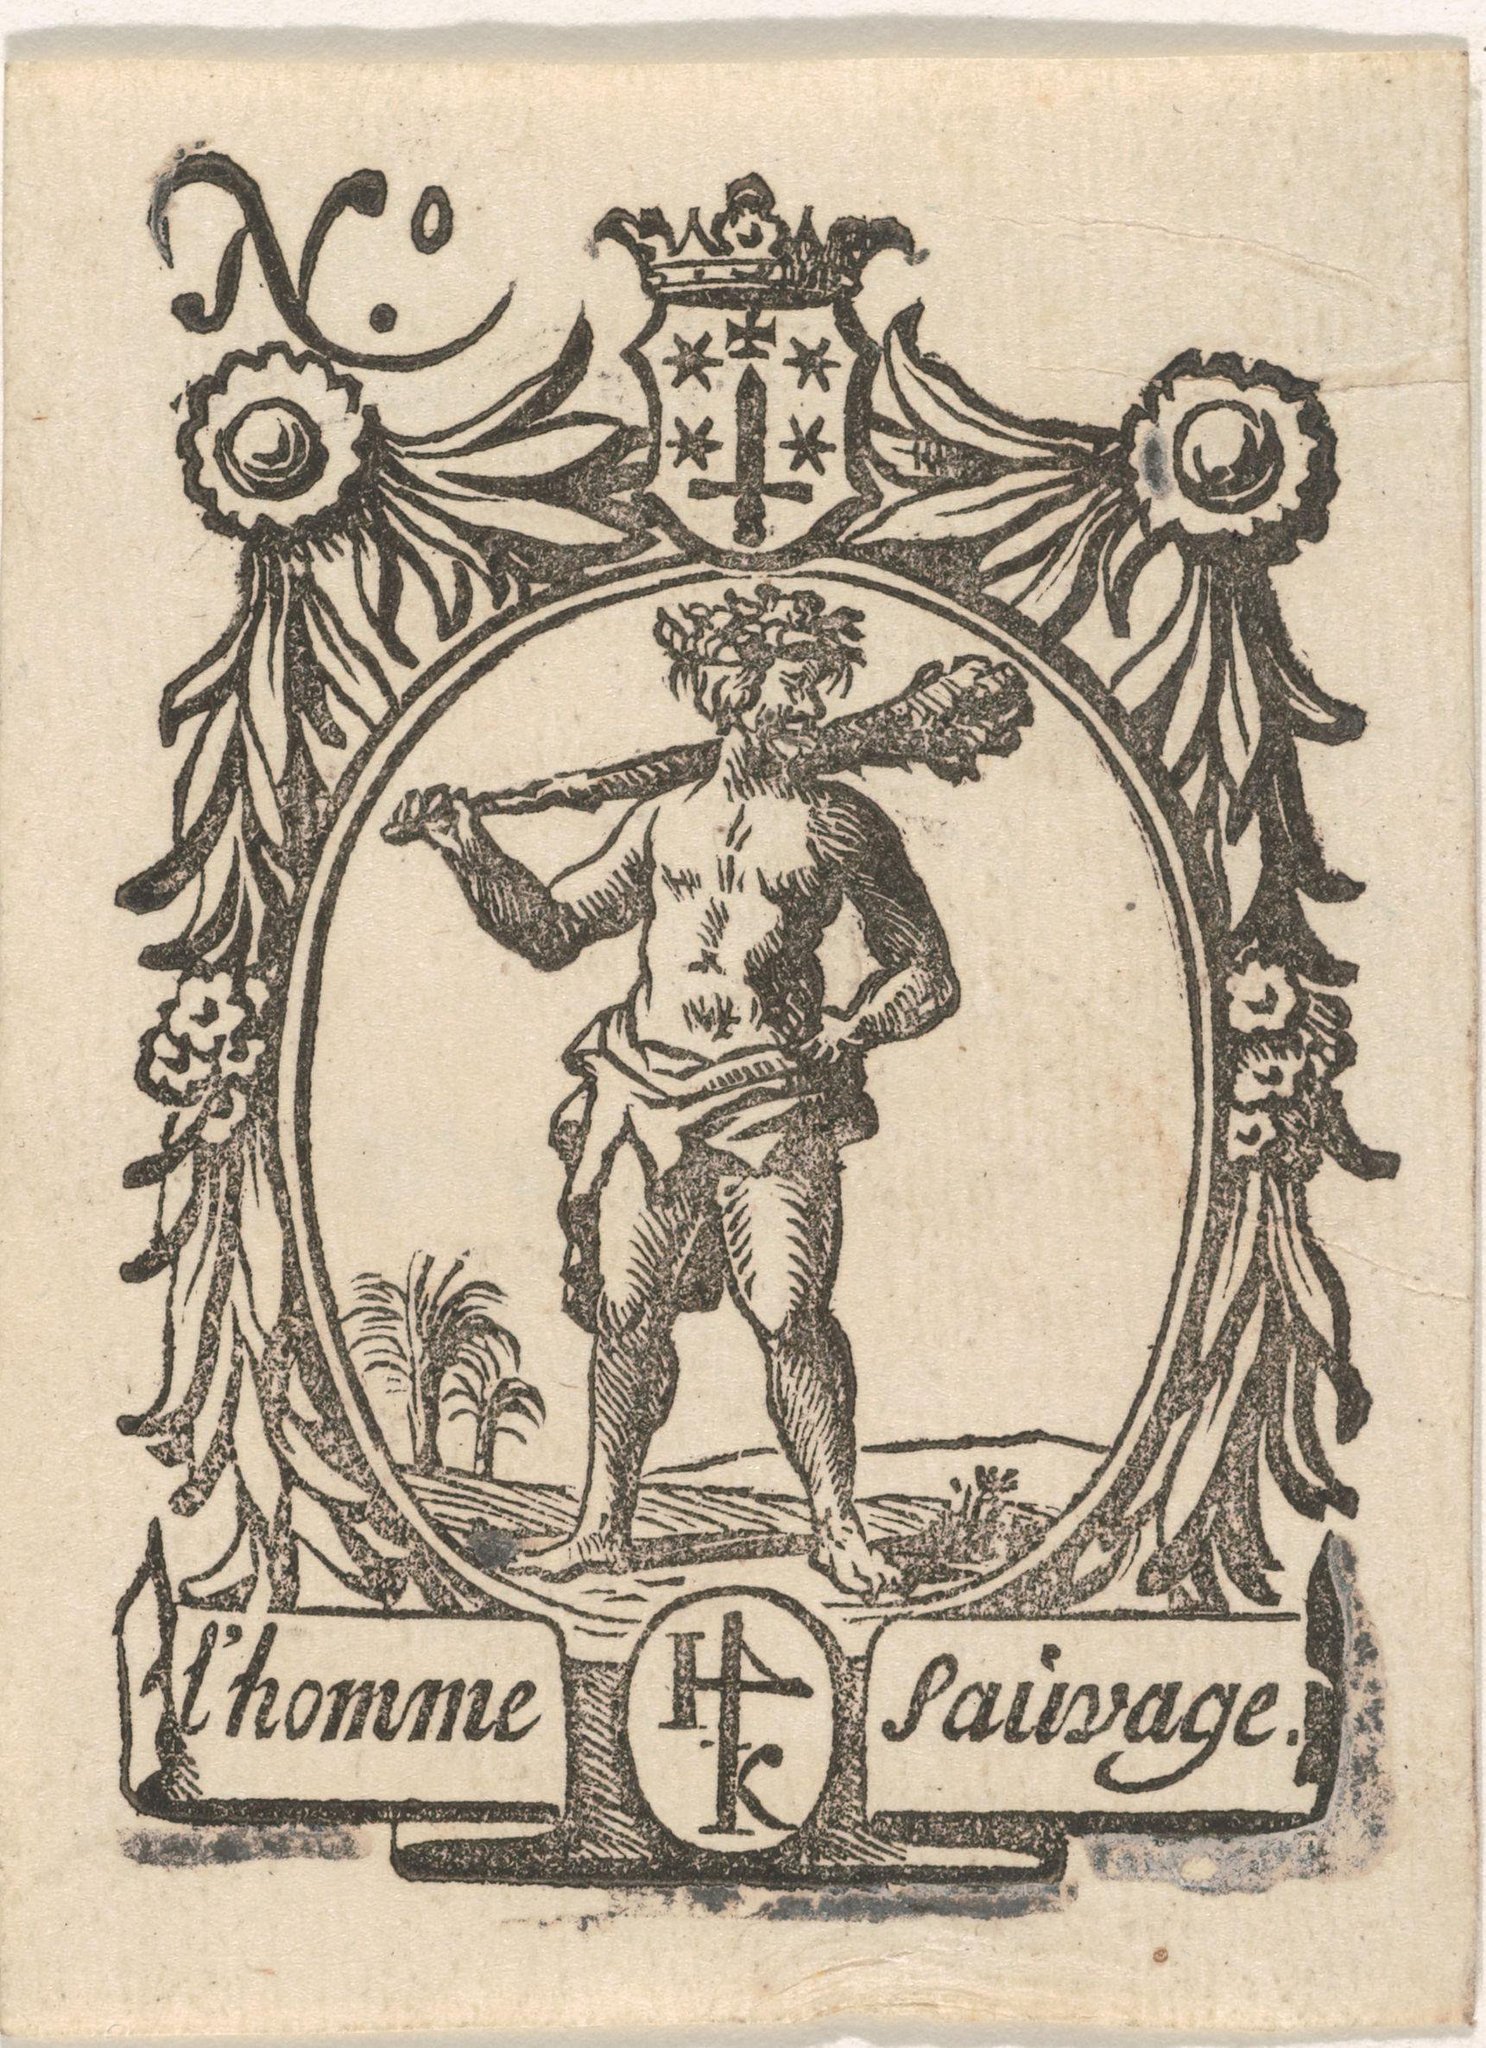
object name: handelsetiket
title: Handelsetiket van Jan Kramer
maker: isaac vincentsz. van der vinne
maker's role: draughtsman, print maker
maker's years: 1665-1740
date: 1681-1740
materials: paper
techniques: woodcut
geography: haarlem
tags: coat of arms (as symbol of the state, etc.) (+ city; municipal), wild man, wodewose, woodehouse, vignette, haarlem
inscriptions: collector's mark: Lugt 240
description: Een wildeman met een knots in een ovaal. Midden boven het wapen van de stad Haarlem. Midden onder een handelsmerk van Jan Kramer.